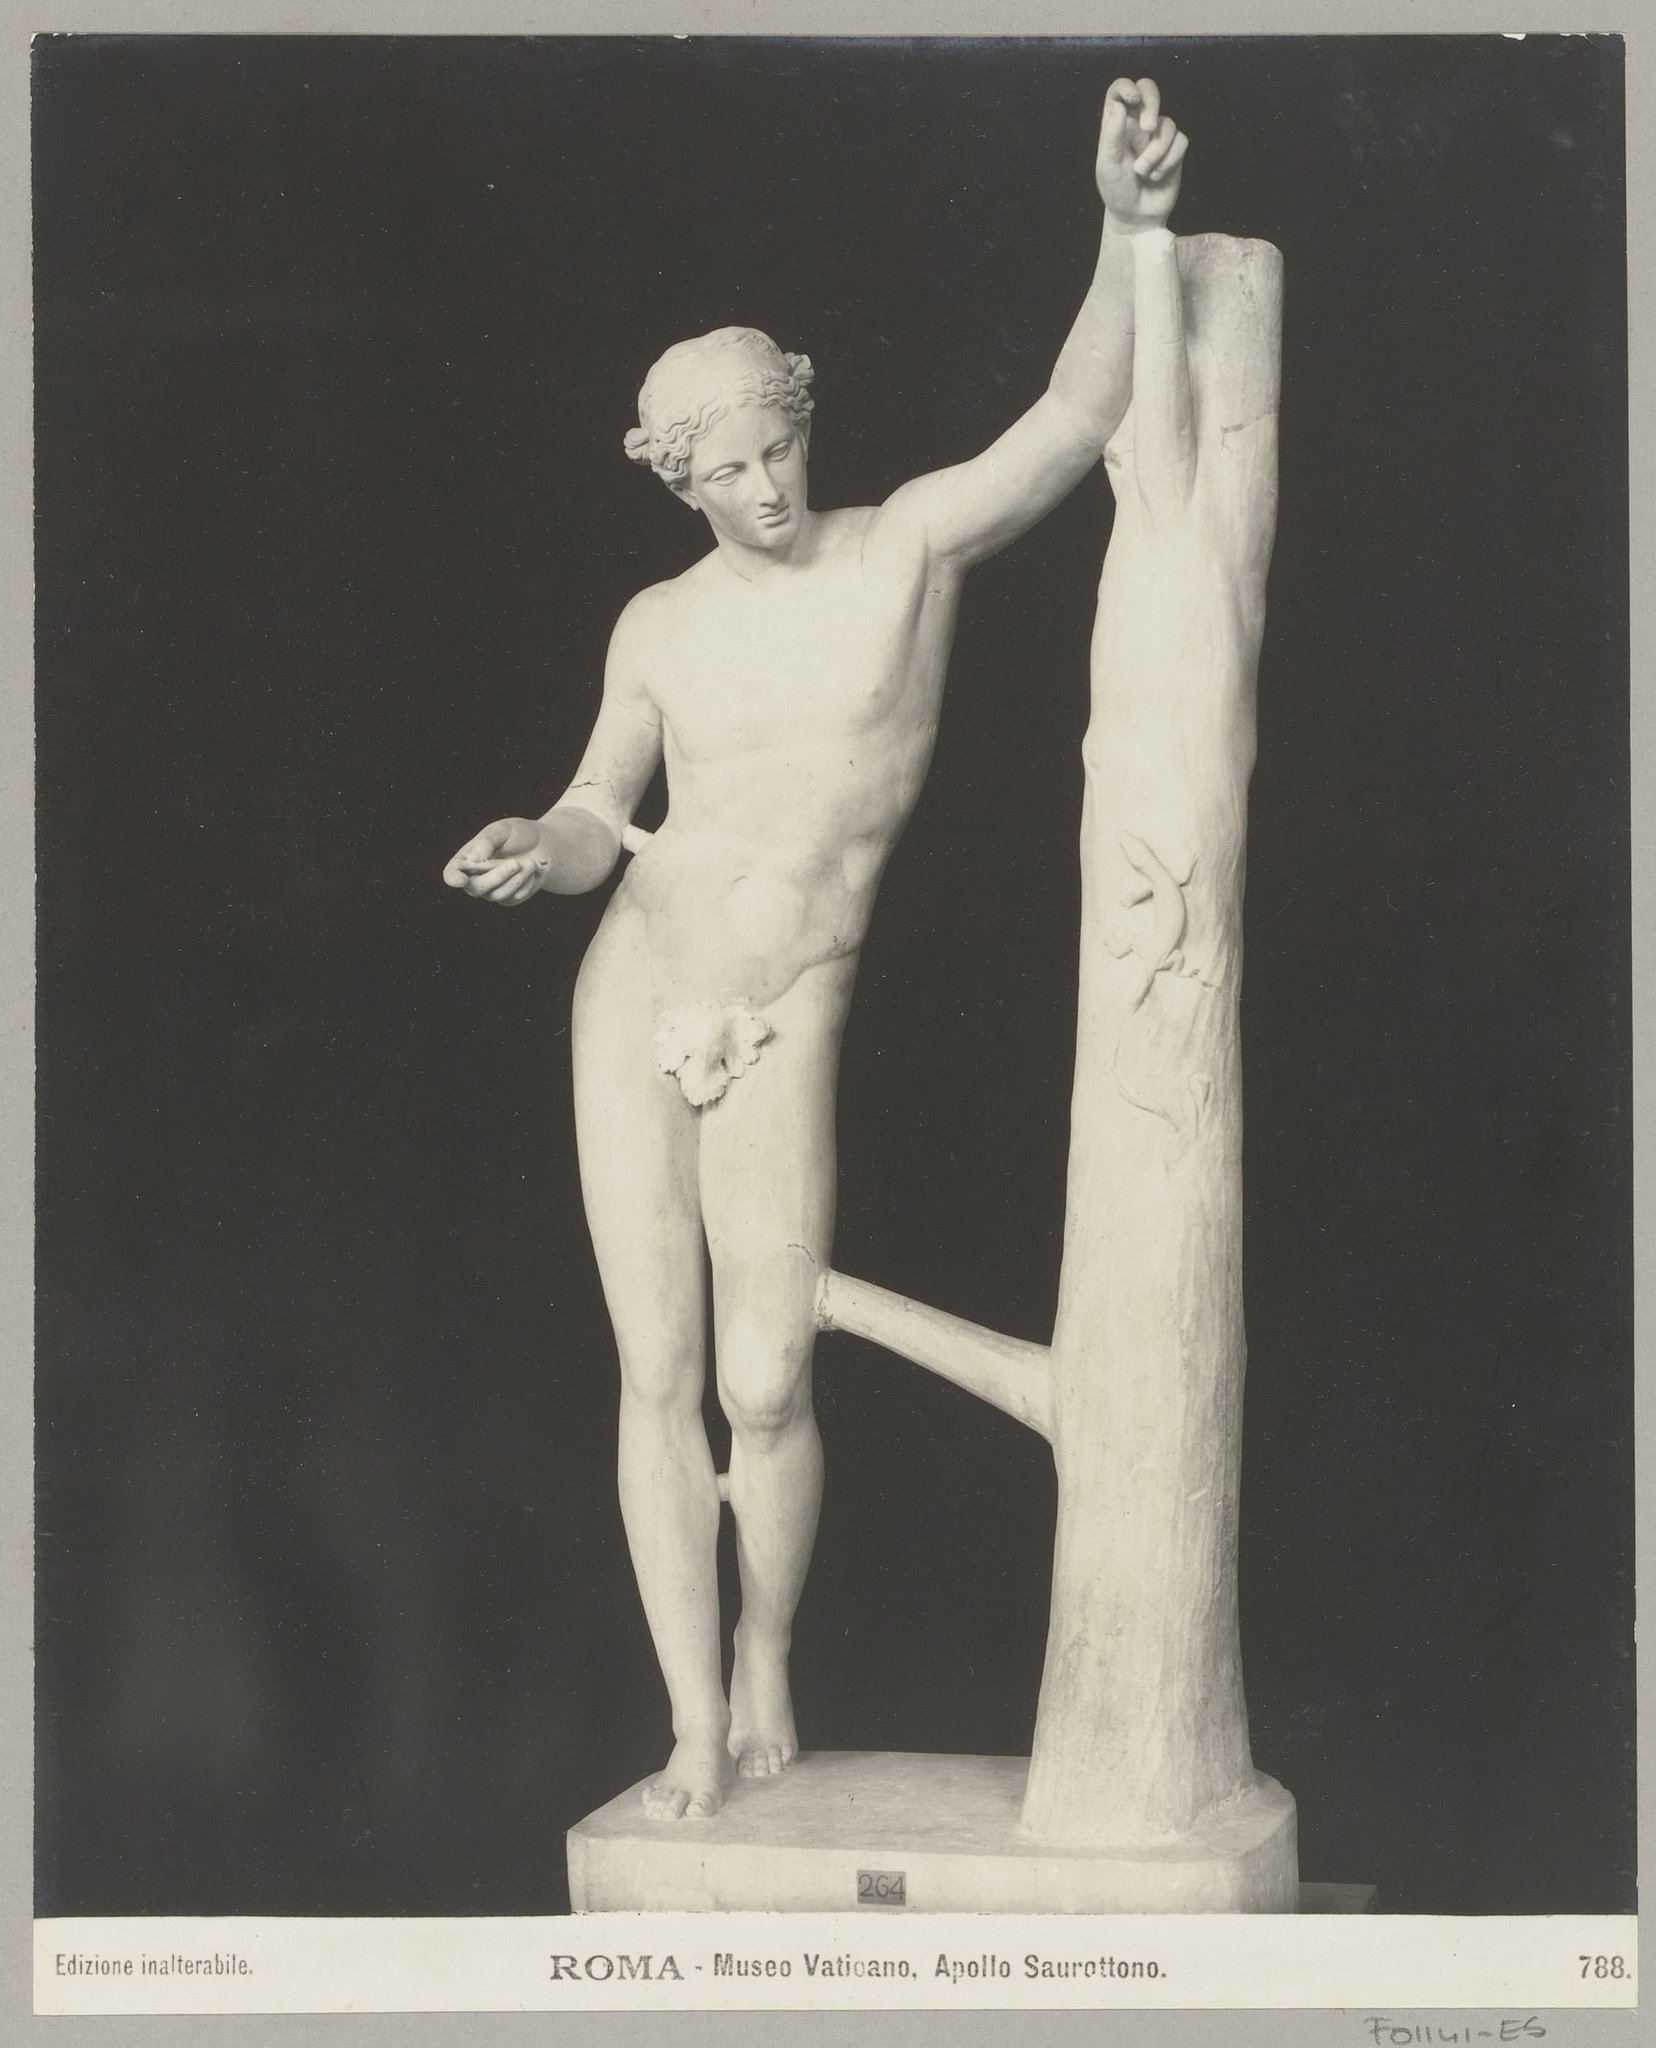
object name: photograph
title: Beeldhouwwerk Apollo Saurottono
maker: Anonymous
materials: photographic support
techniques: gelatin silver print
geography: vatican city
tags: (story of) apollo (phoebus), piece of sculpture, reproduction of a piece of sculpture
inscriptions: number: ‘788’, inscription: ‘Edizione inalterabile’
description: Onderdeel van Fotoalbum van een reis door Zuid-Europa en het Midden-Oosten.